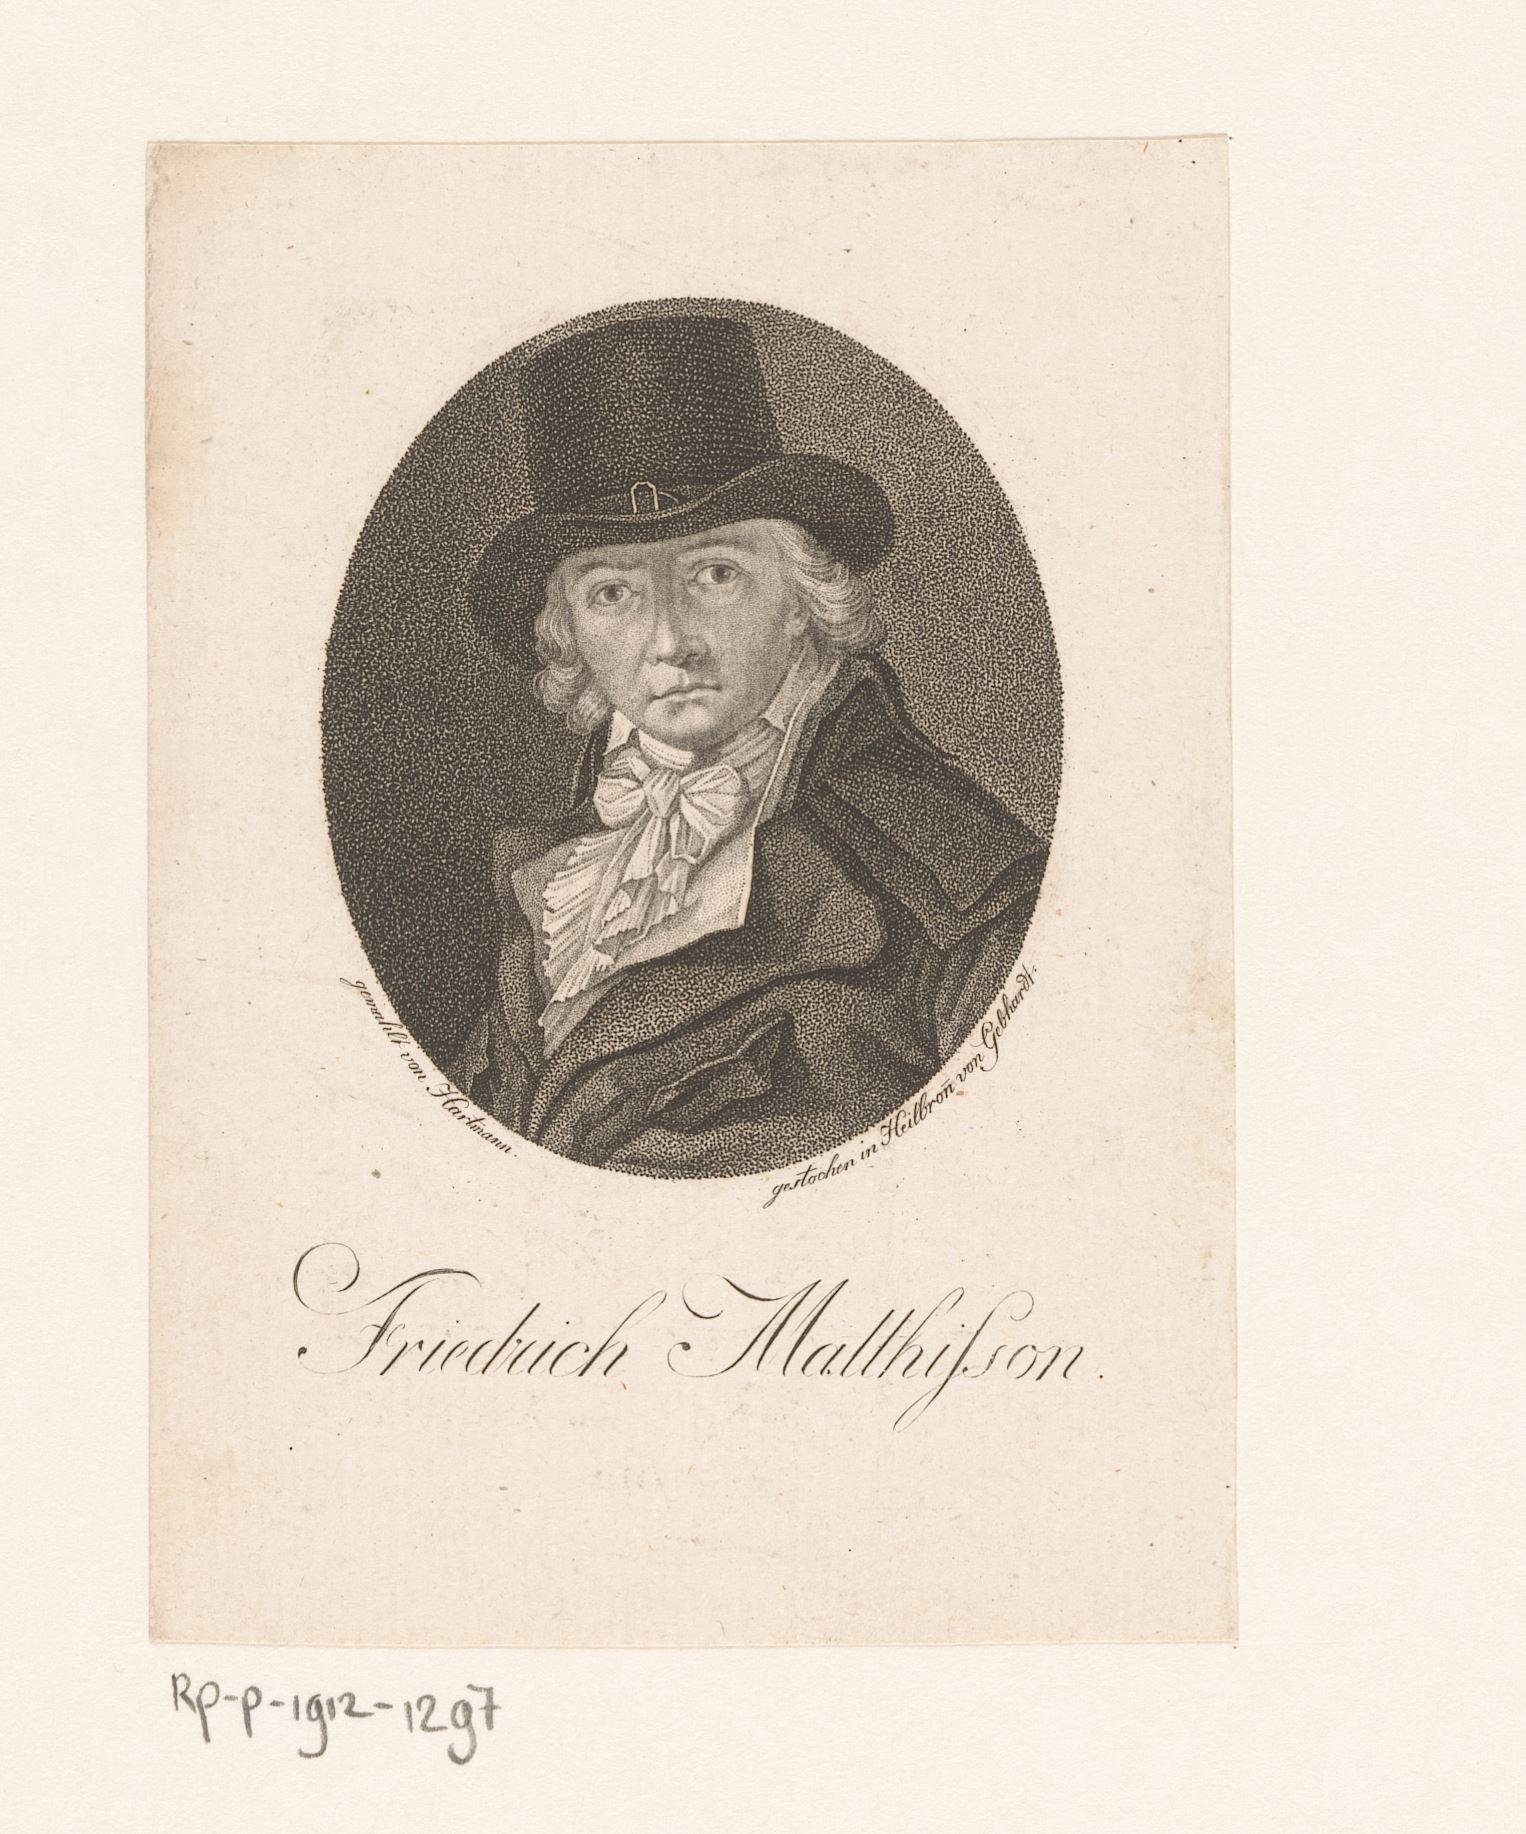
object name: print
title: Portret van Friedrich von Matthisson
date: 1775-1800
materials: paper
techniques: etching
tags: writer, poet, author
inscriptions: collector's mark: Lugt 2228